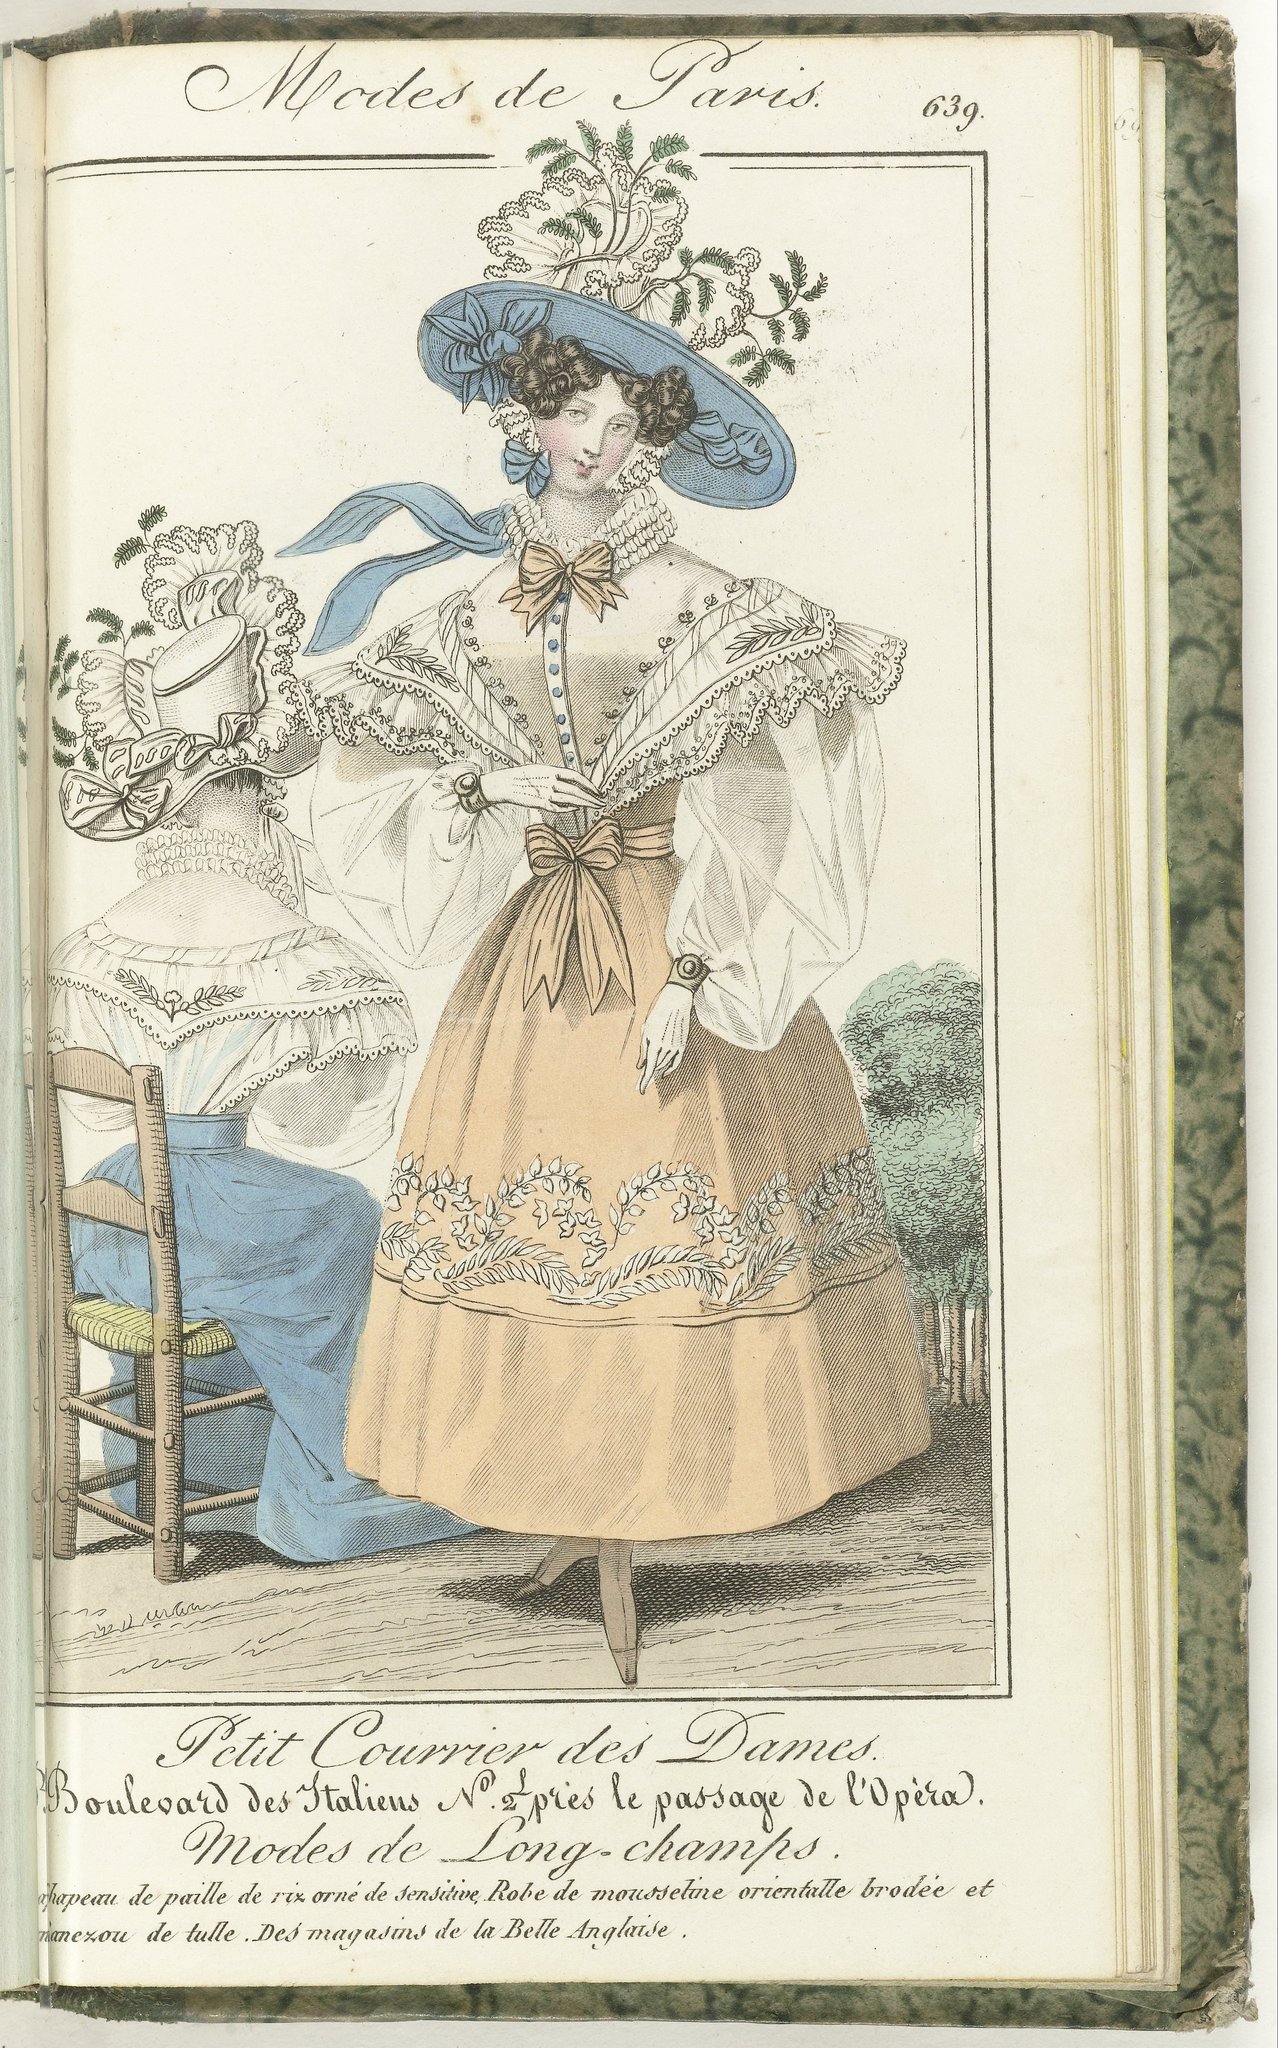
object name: fashion print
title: Petit Courrier des Dames, 20 mai 1829, No. 639 : Modes de Long-champs...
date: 1829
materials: paper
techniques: engraving, hand coloring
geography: paris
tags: embroidery (ornamentation) (+ women's clothes), clothing for the upper part of the body: blouse (+ women's clothes), head-gear (straw hat) (+ women's clothes), fashion plates, dress, gown (+ women's clothes), bracelet, wristlet (+ women's clothes)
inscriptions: title: ‘Petit Courrier des Dames.’, address: ‘Boulevard des Italiens No.2 près le passage de l'Opèra.’, caption: ‘Modes de Long-champs. Chapeau de paille de riz orné de sensitive. Robe de mousseline orientalle brodée et Canezou de tulle. Des magasins de la Belle Anglaise.’, title: ‘Modes de Paris.’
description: 'Modes de Long-champs.' Japon van geborduurde 'mousseline orientalle' en een canezou van tule. Hoed van 'paille de riz' versierd met kruidje-roer-mij-niet (mimosa pudica). Prent uit het modetijdschrift Petit Courrier des Dames (1821-1868). Ingebonden (met enkele pag. Le Journal des Dames et des Modes). 15 Januari 1827 t/m 20 maart 1830. Incompleet.